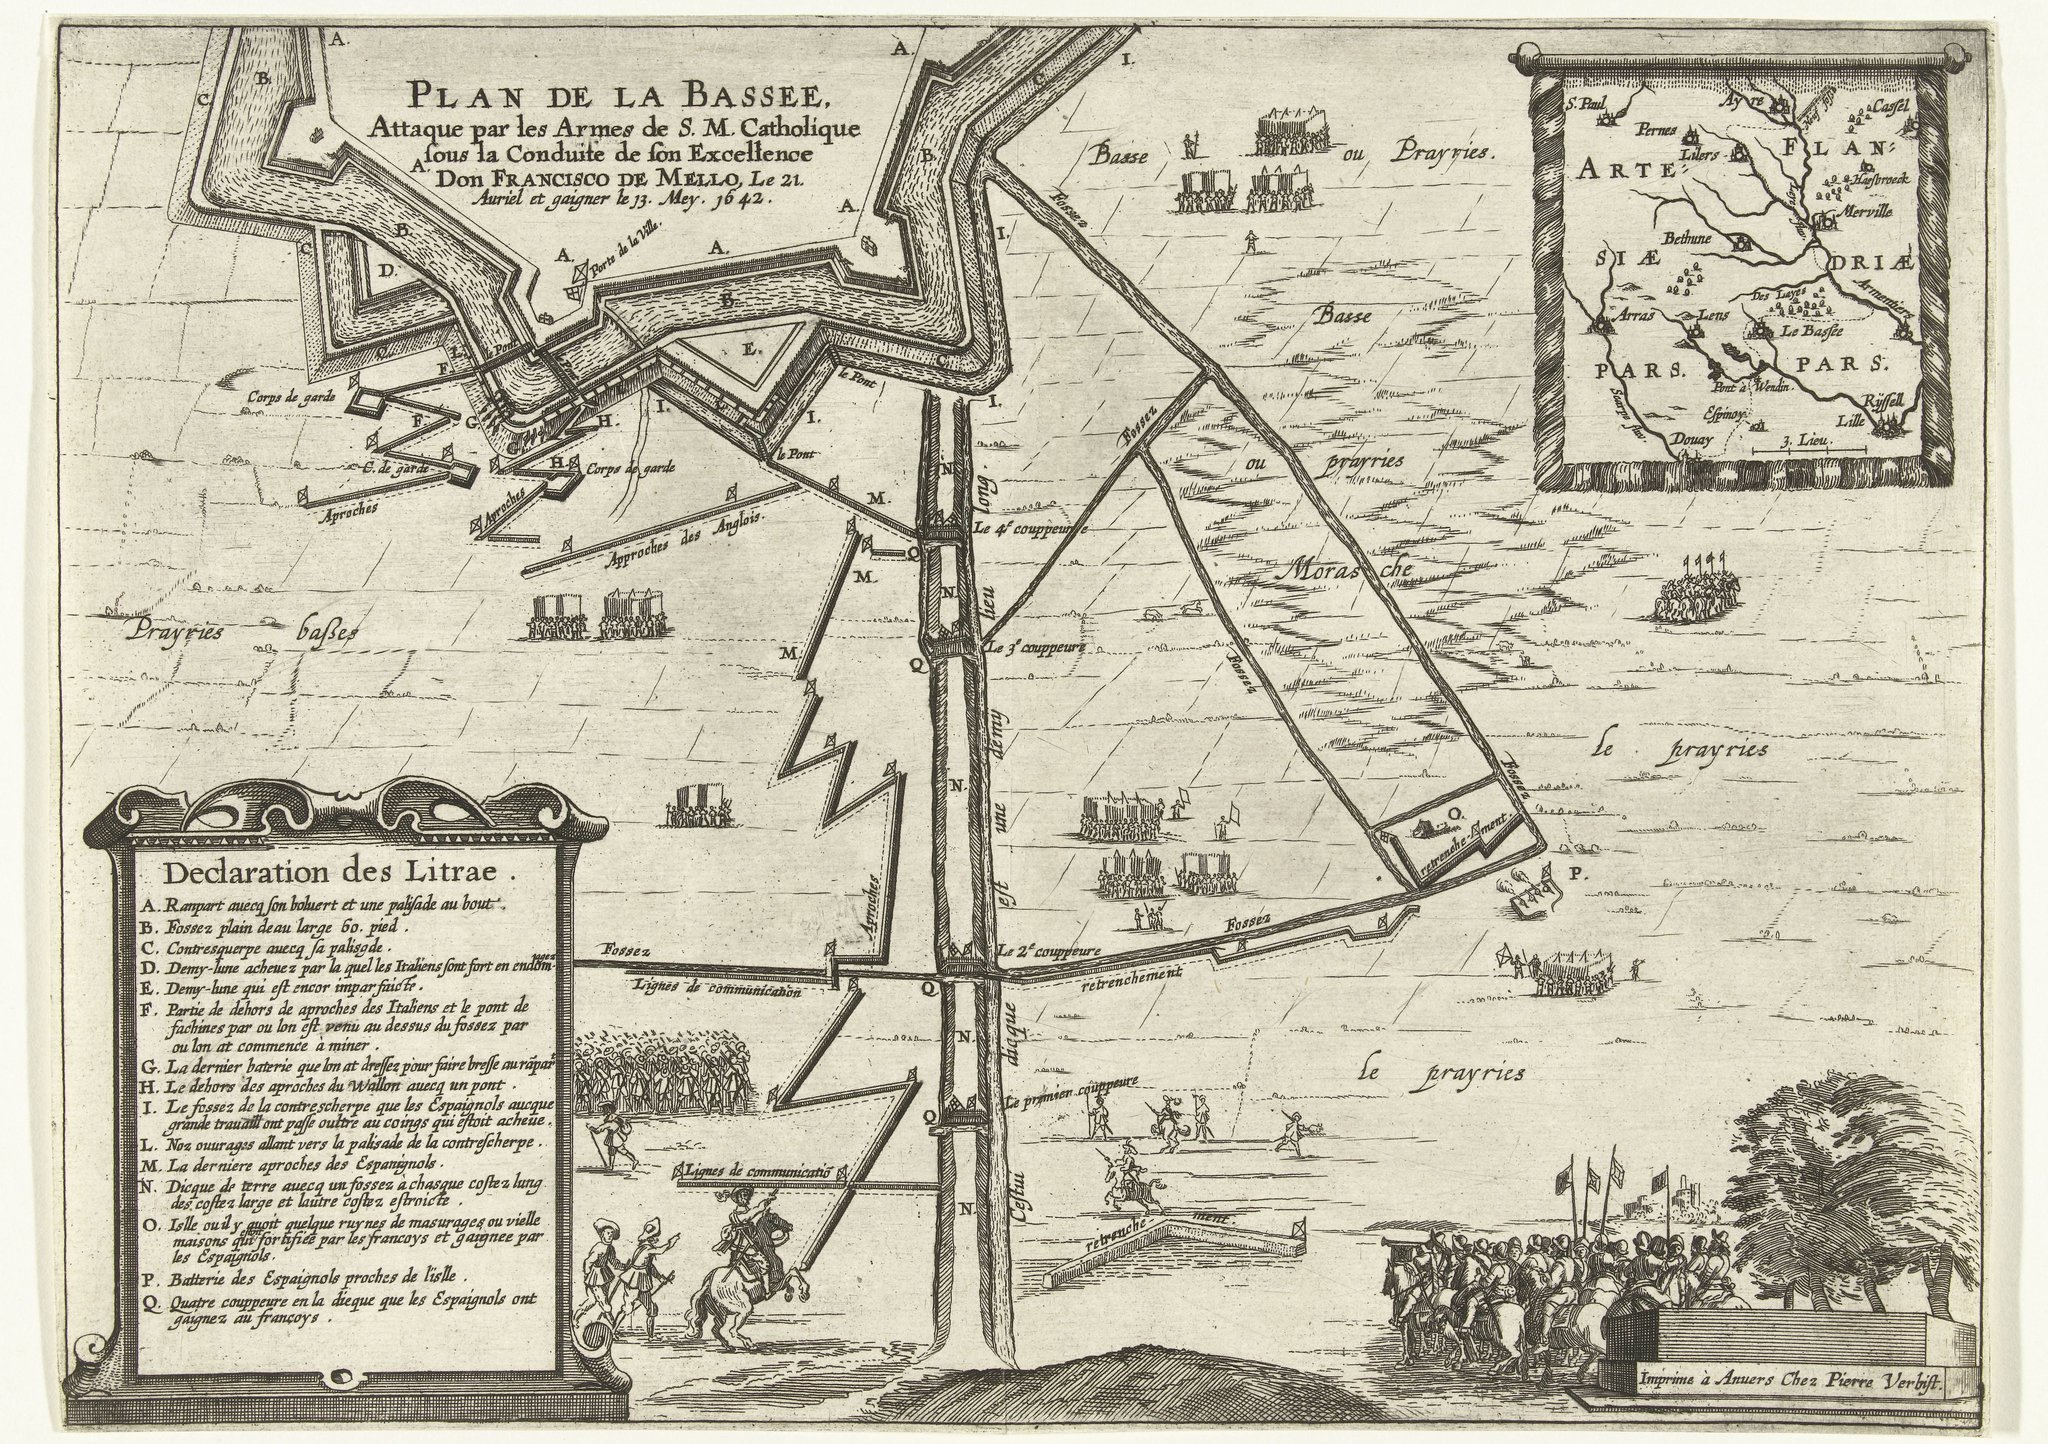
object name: print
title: Plan de La Bassee, Attaque par les Armes de S.M. Catholique dous la Conduite de son Excellence Don Francisco de Mello, Le 21. Avriel et gaigner le 13. Mey. 1642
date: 1642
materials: paper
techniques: engraving, etching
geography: antwerp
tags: maps of separate countries or regions, siege, position war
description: Kaart met de herovering van de vestingstad La Bassée door het Spaanse leger onder landvoogd Francisco de Melo op 11 mei na een belegering begonnen op 19 april 1642. Bovenaan een deel van de versterkte stad, daaronder de dijken en loopgraven aangelegd door de belegeraars. Rechtsboven op een kleed een kaart van het groter gebied. Linksonder de legenda A-Q in het Frans, rechtsonder een groep ruiters.